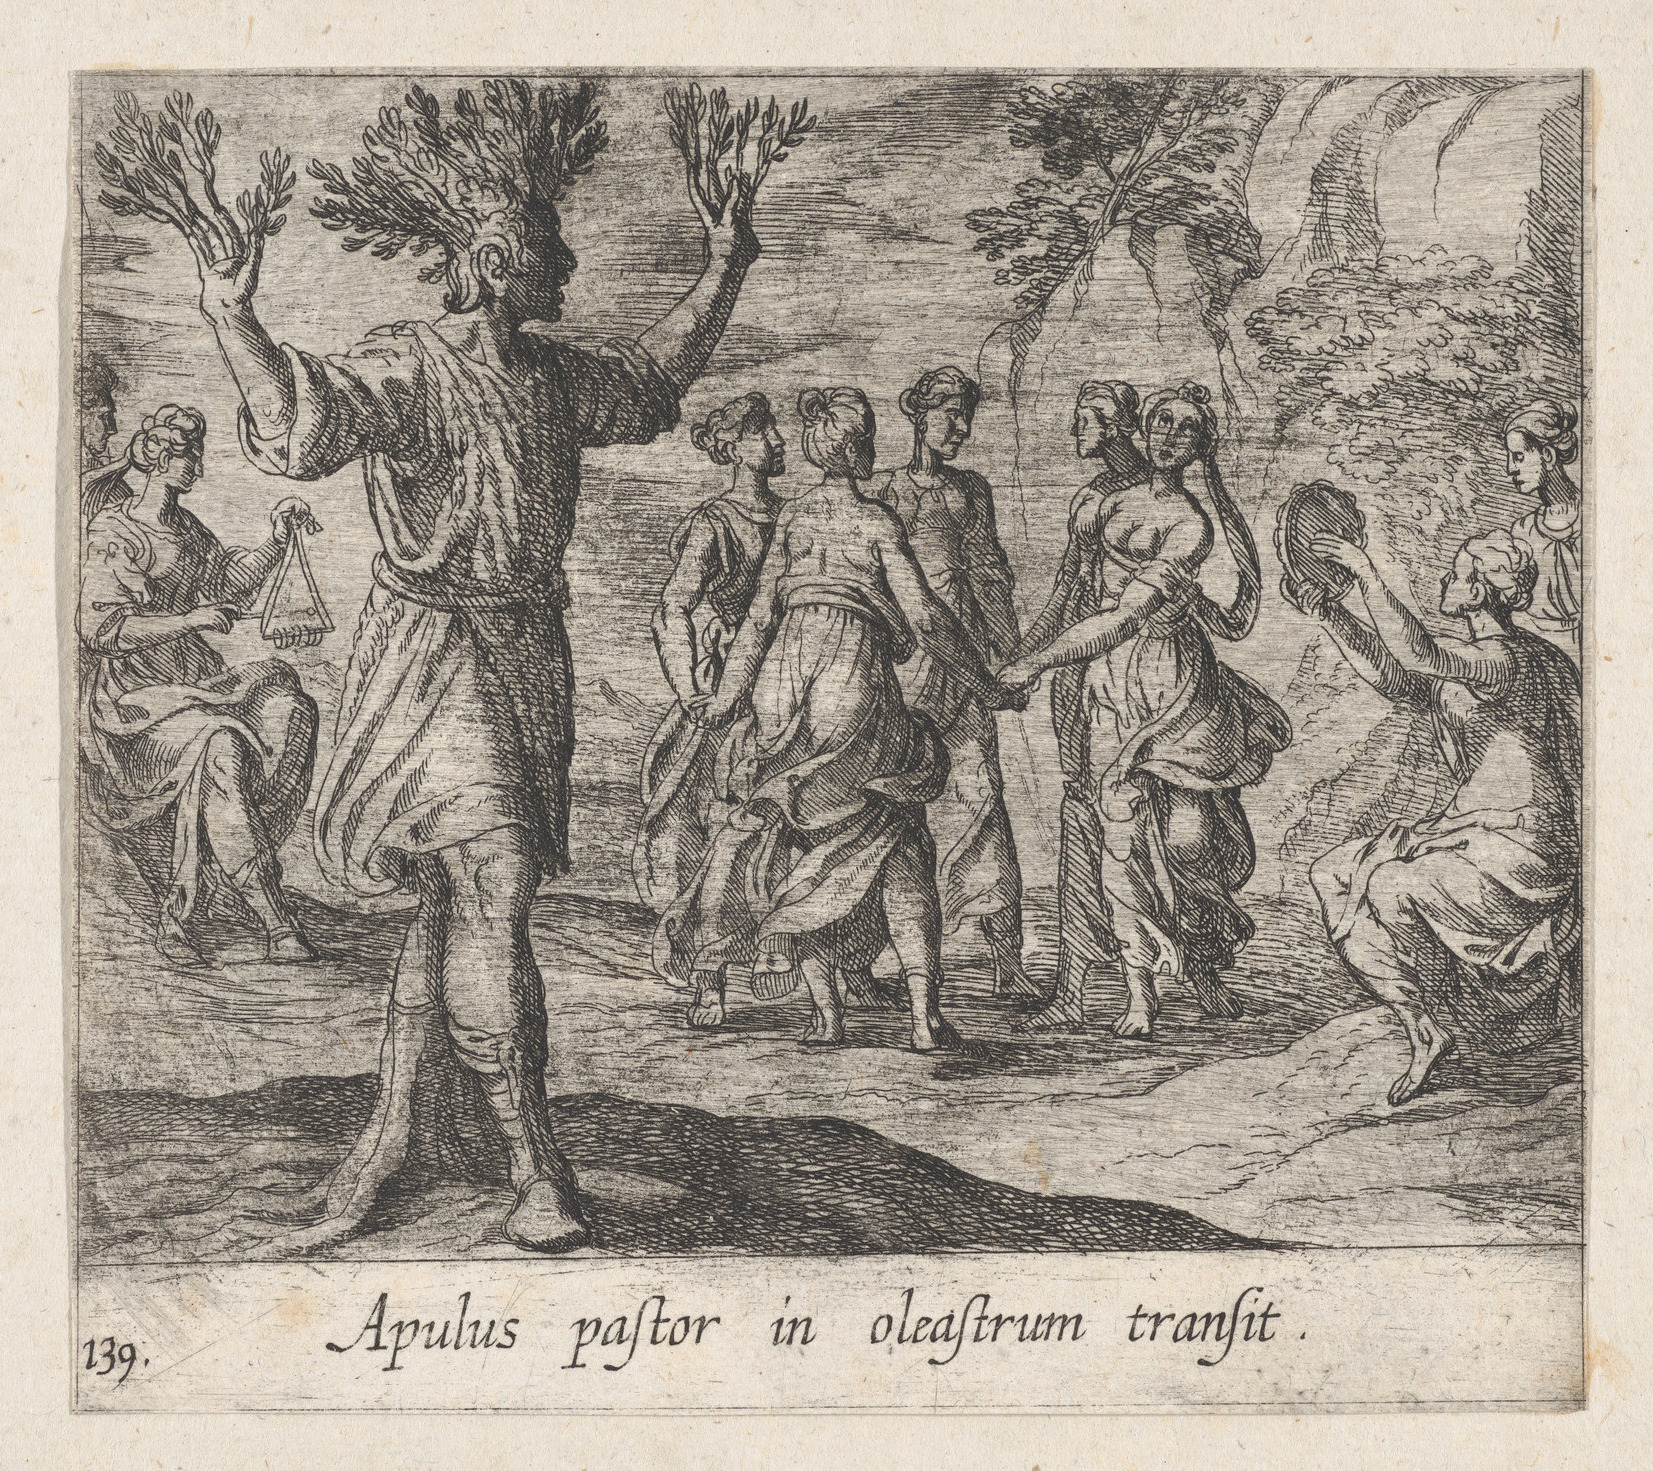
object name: print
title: Plate 139: The Apulian Shepherd Changed into an Olive Tree (Apulus pastor in oleastrum transit), from Ovid's 'Metamorphoses'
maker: antonio tempesta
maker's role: artist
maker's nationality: italian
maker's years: 1555-1630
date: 1606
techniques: etching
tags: musical instruments,women,dancing,shepherds